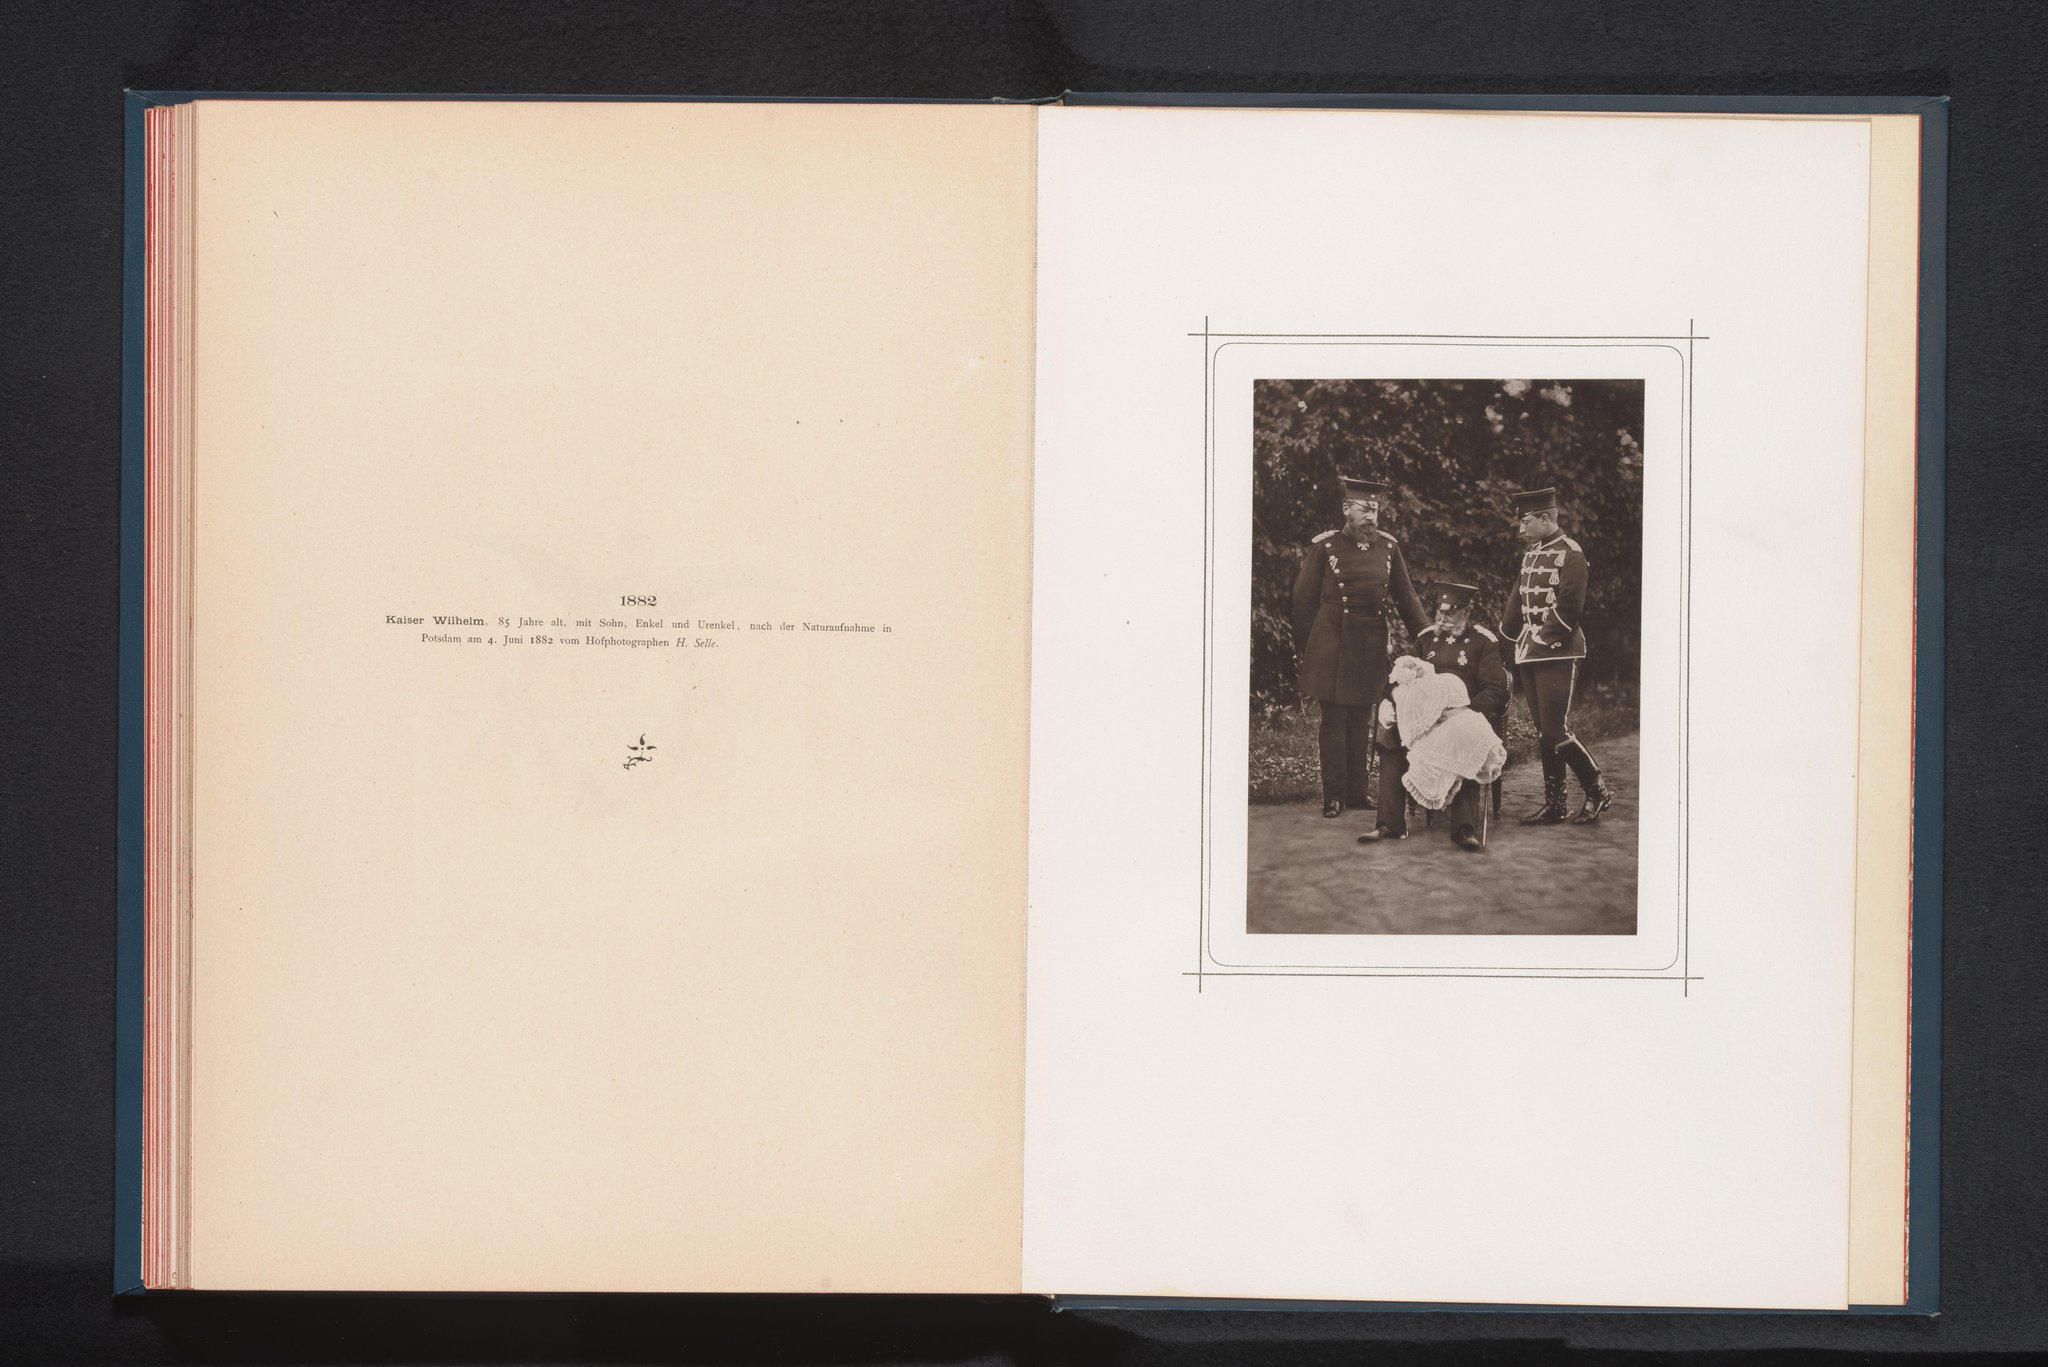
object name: photomechanical print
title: Portret van Wilhelm I met zijn zoon, kleinzoon en achterkleinzoon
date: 1882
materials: paper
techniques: photograph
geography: potsdam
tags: berlin, wilhelm i (keizer van duitsland), wilhelm ii (keizer van duitsland), royal children, ruler, sovereign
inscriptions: inscription: ‘1882 Kaiser Wilhelm, 85 Jahre alt, mit Sohn, Enkel und Urenkel, nach der Naturaufnahme in Potsdam am 4. Juni 1882 vom Hofphotographen H. Selle.’